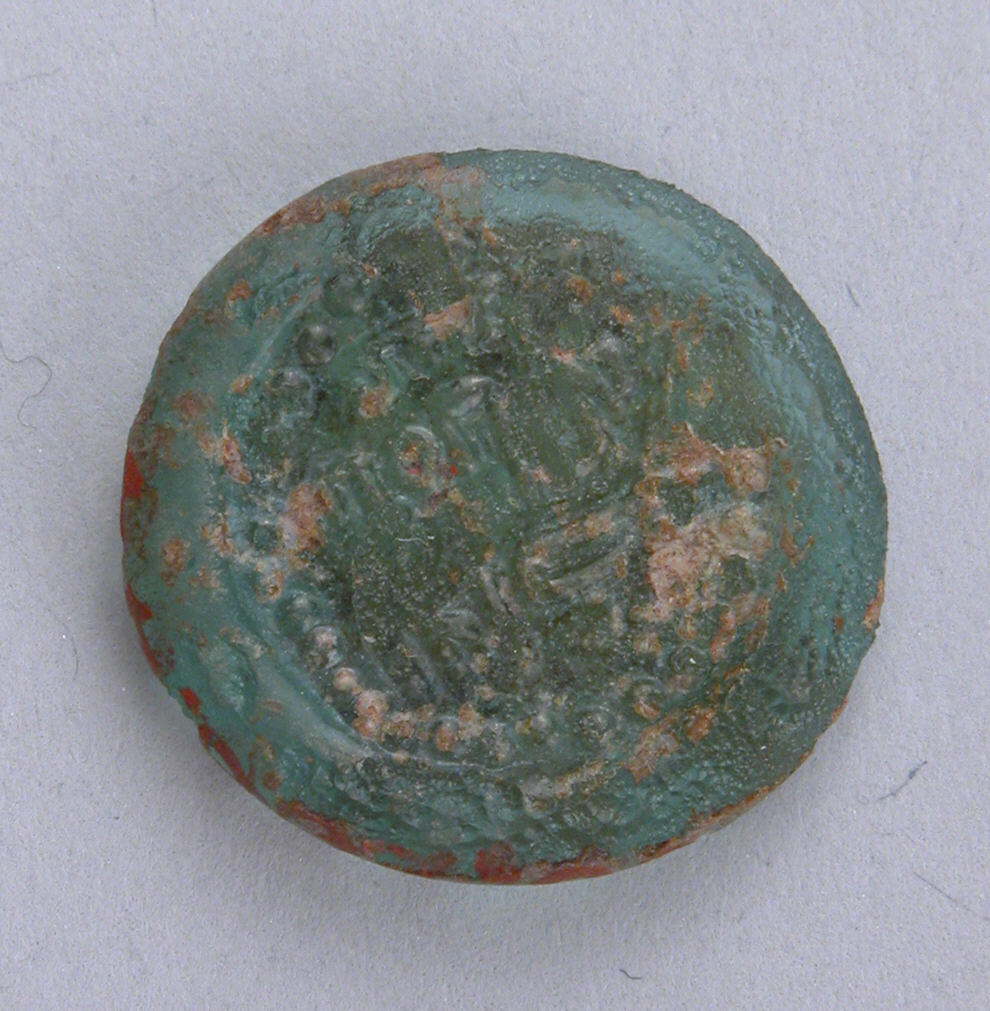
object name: coin weight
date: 901-1100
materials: glass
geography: egypt